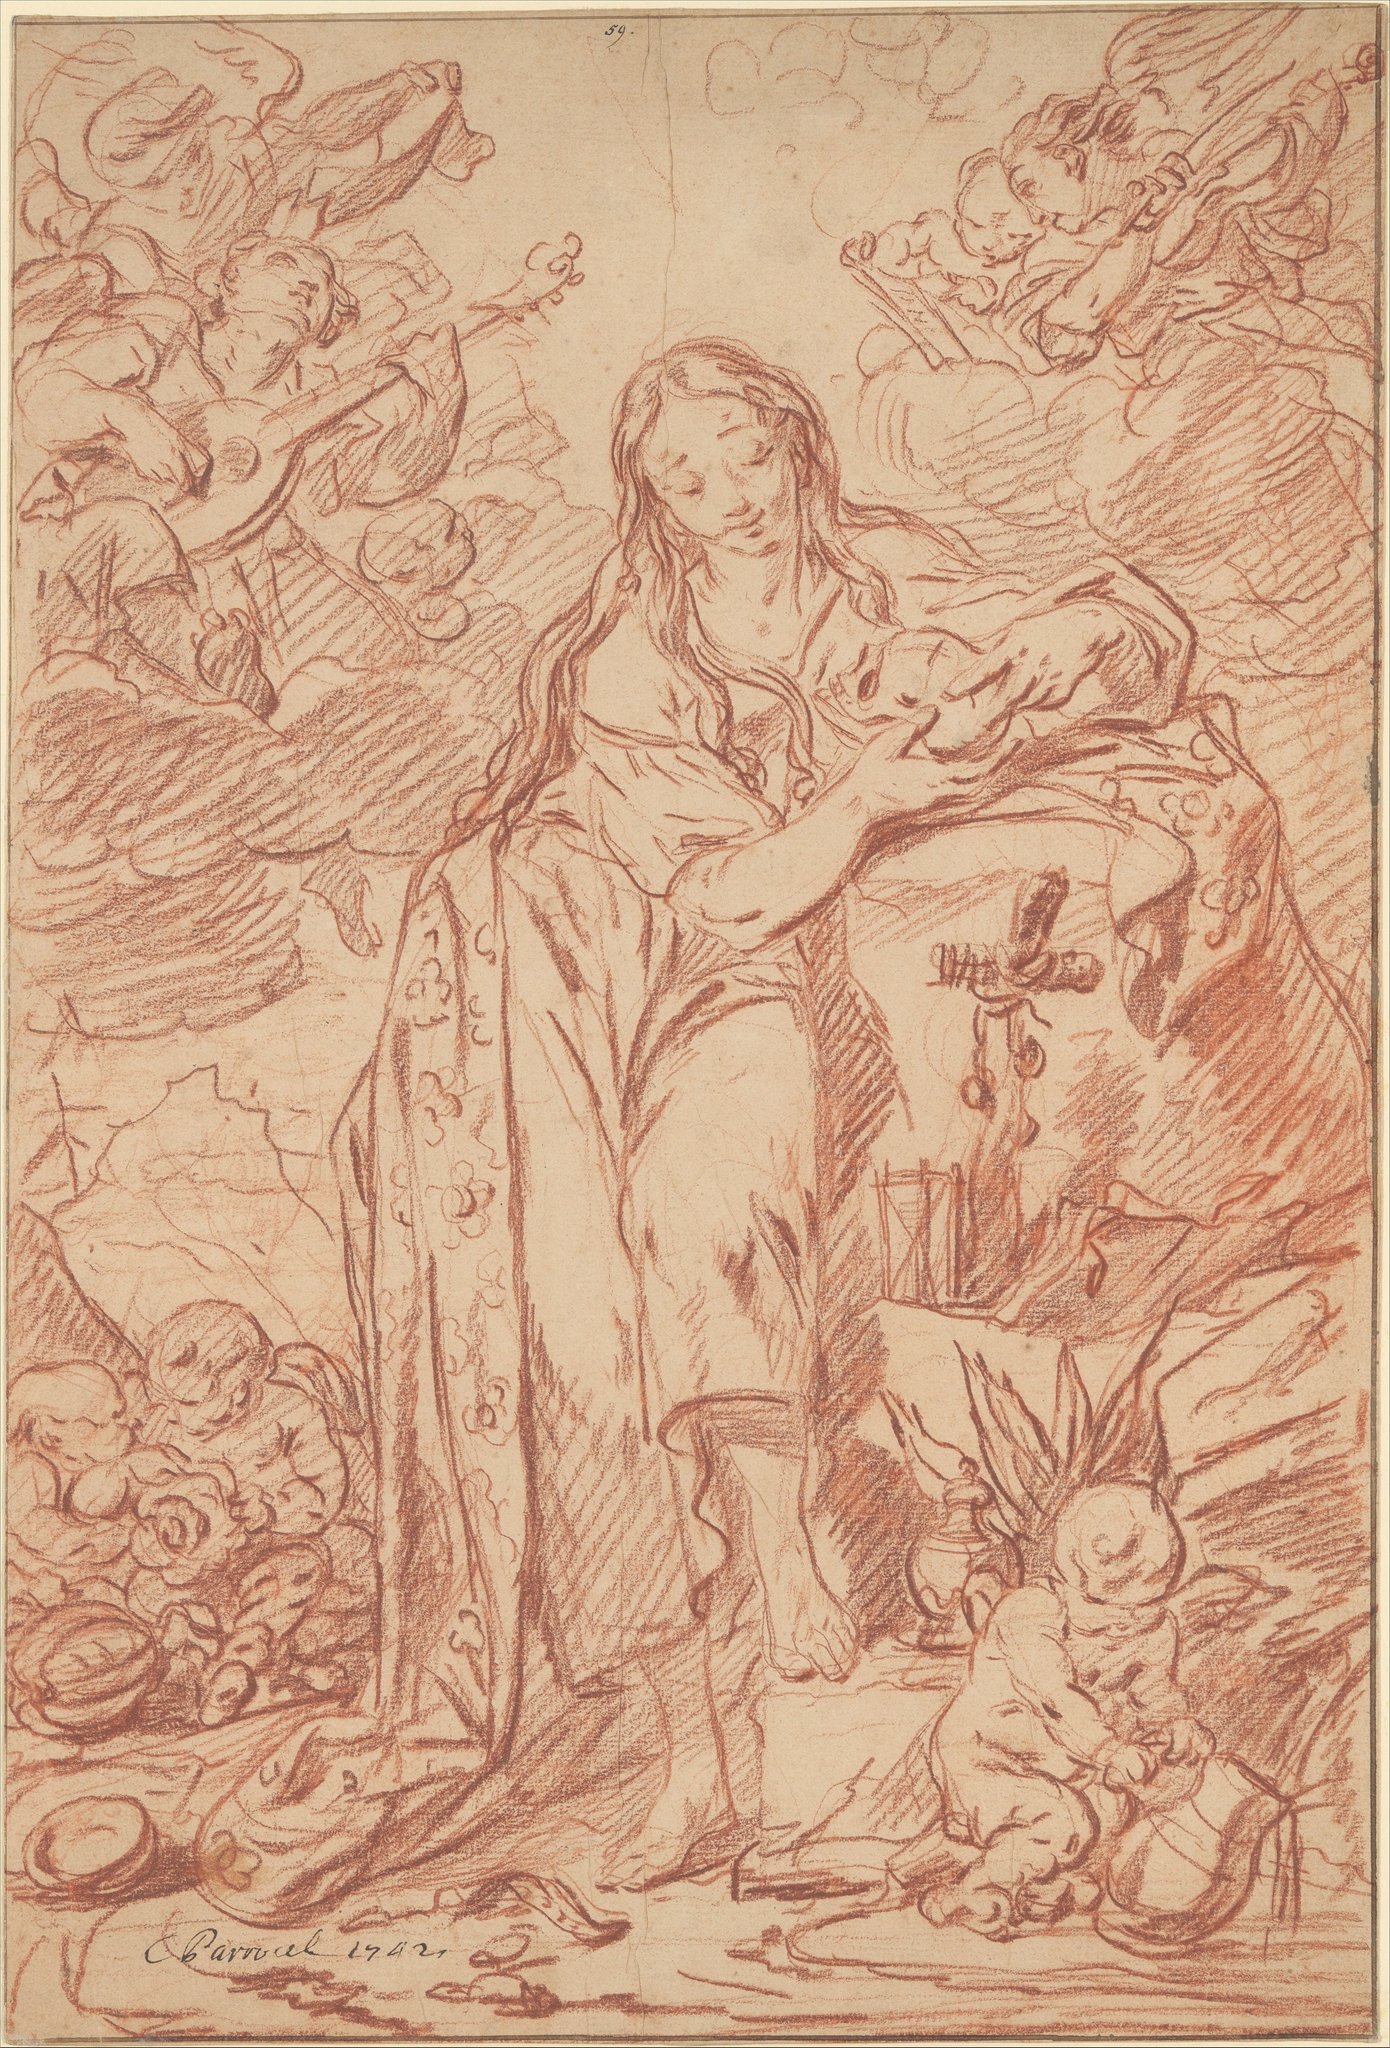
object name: drawing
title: The Penitent St. Mary Magdalen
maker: charles parrocel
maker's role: artist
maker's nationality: french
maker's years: 1688-1752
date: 1742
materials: chalk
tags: human figures,musical instruments,angels,mary magdalene